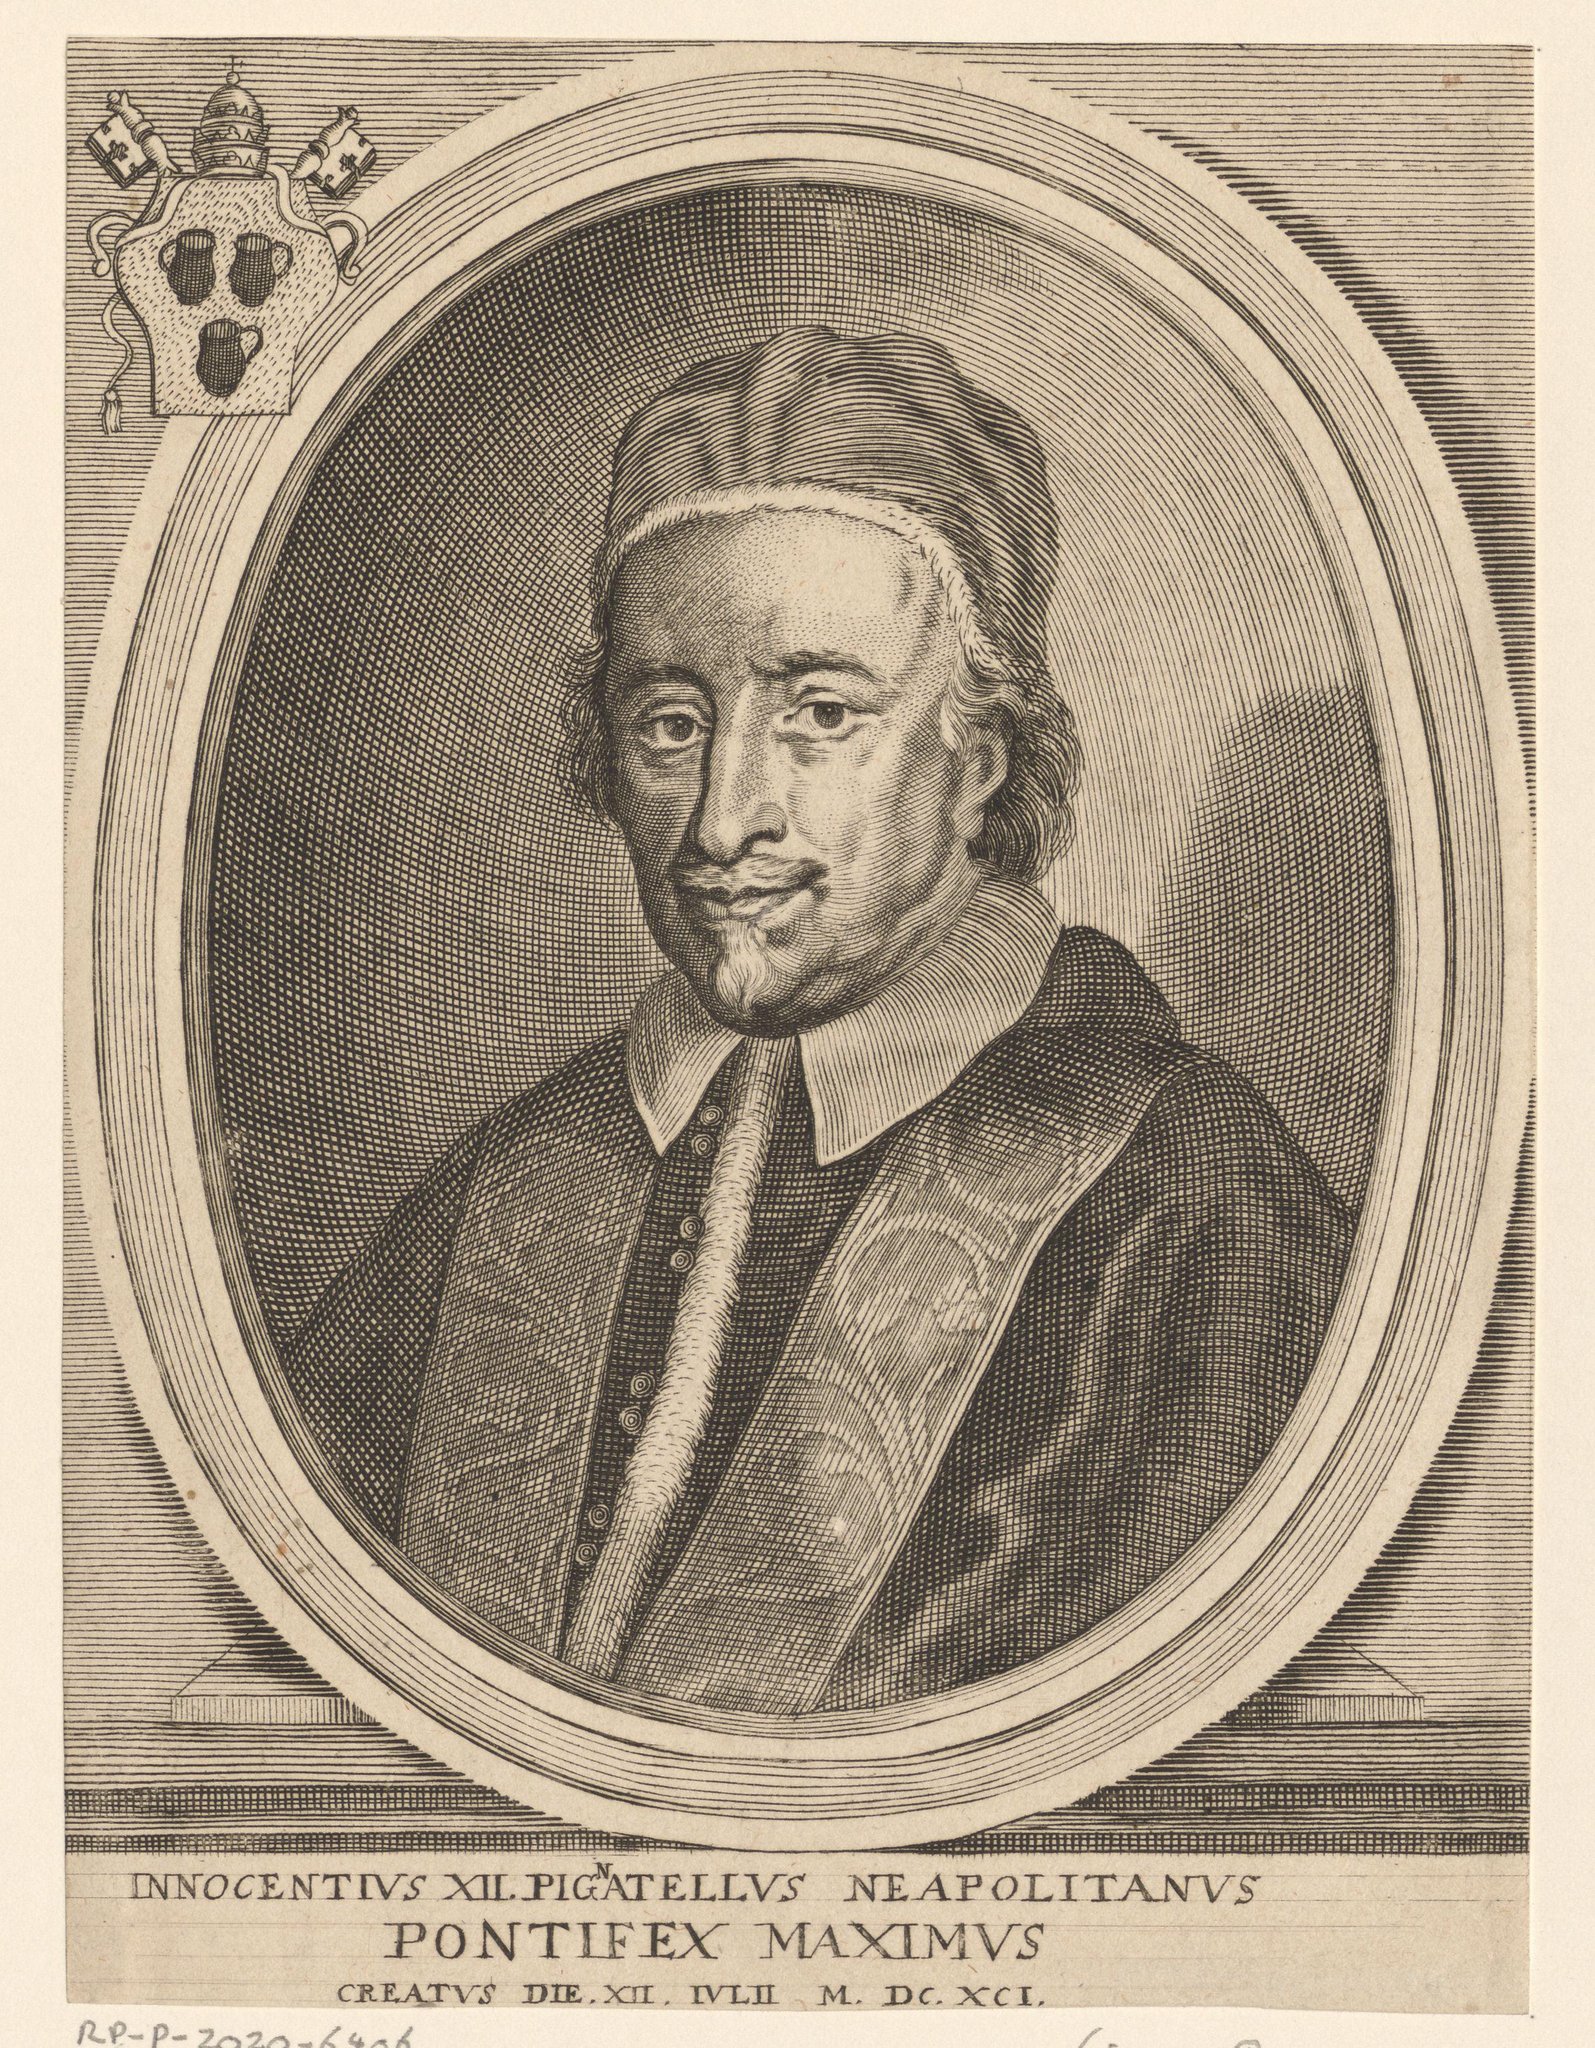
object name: print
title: Portret van paus Innocentius XII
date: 1691-1724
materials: paper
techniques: engraving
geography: augsburg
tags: rome, clergyman, innocentius xii, historical persons, pope, armorial bearing, heraldry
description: Met linksboven het portret zijn wapenschild.